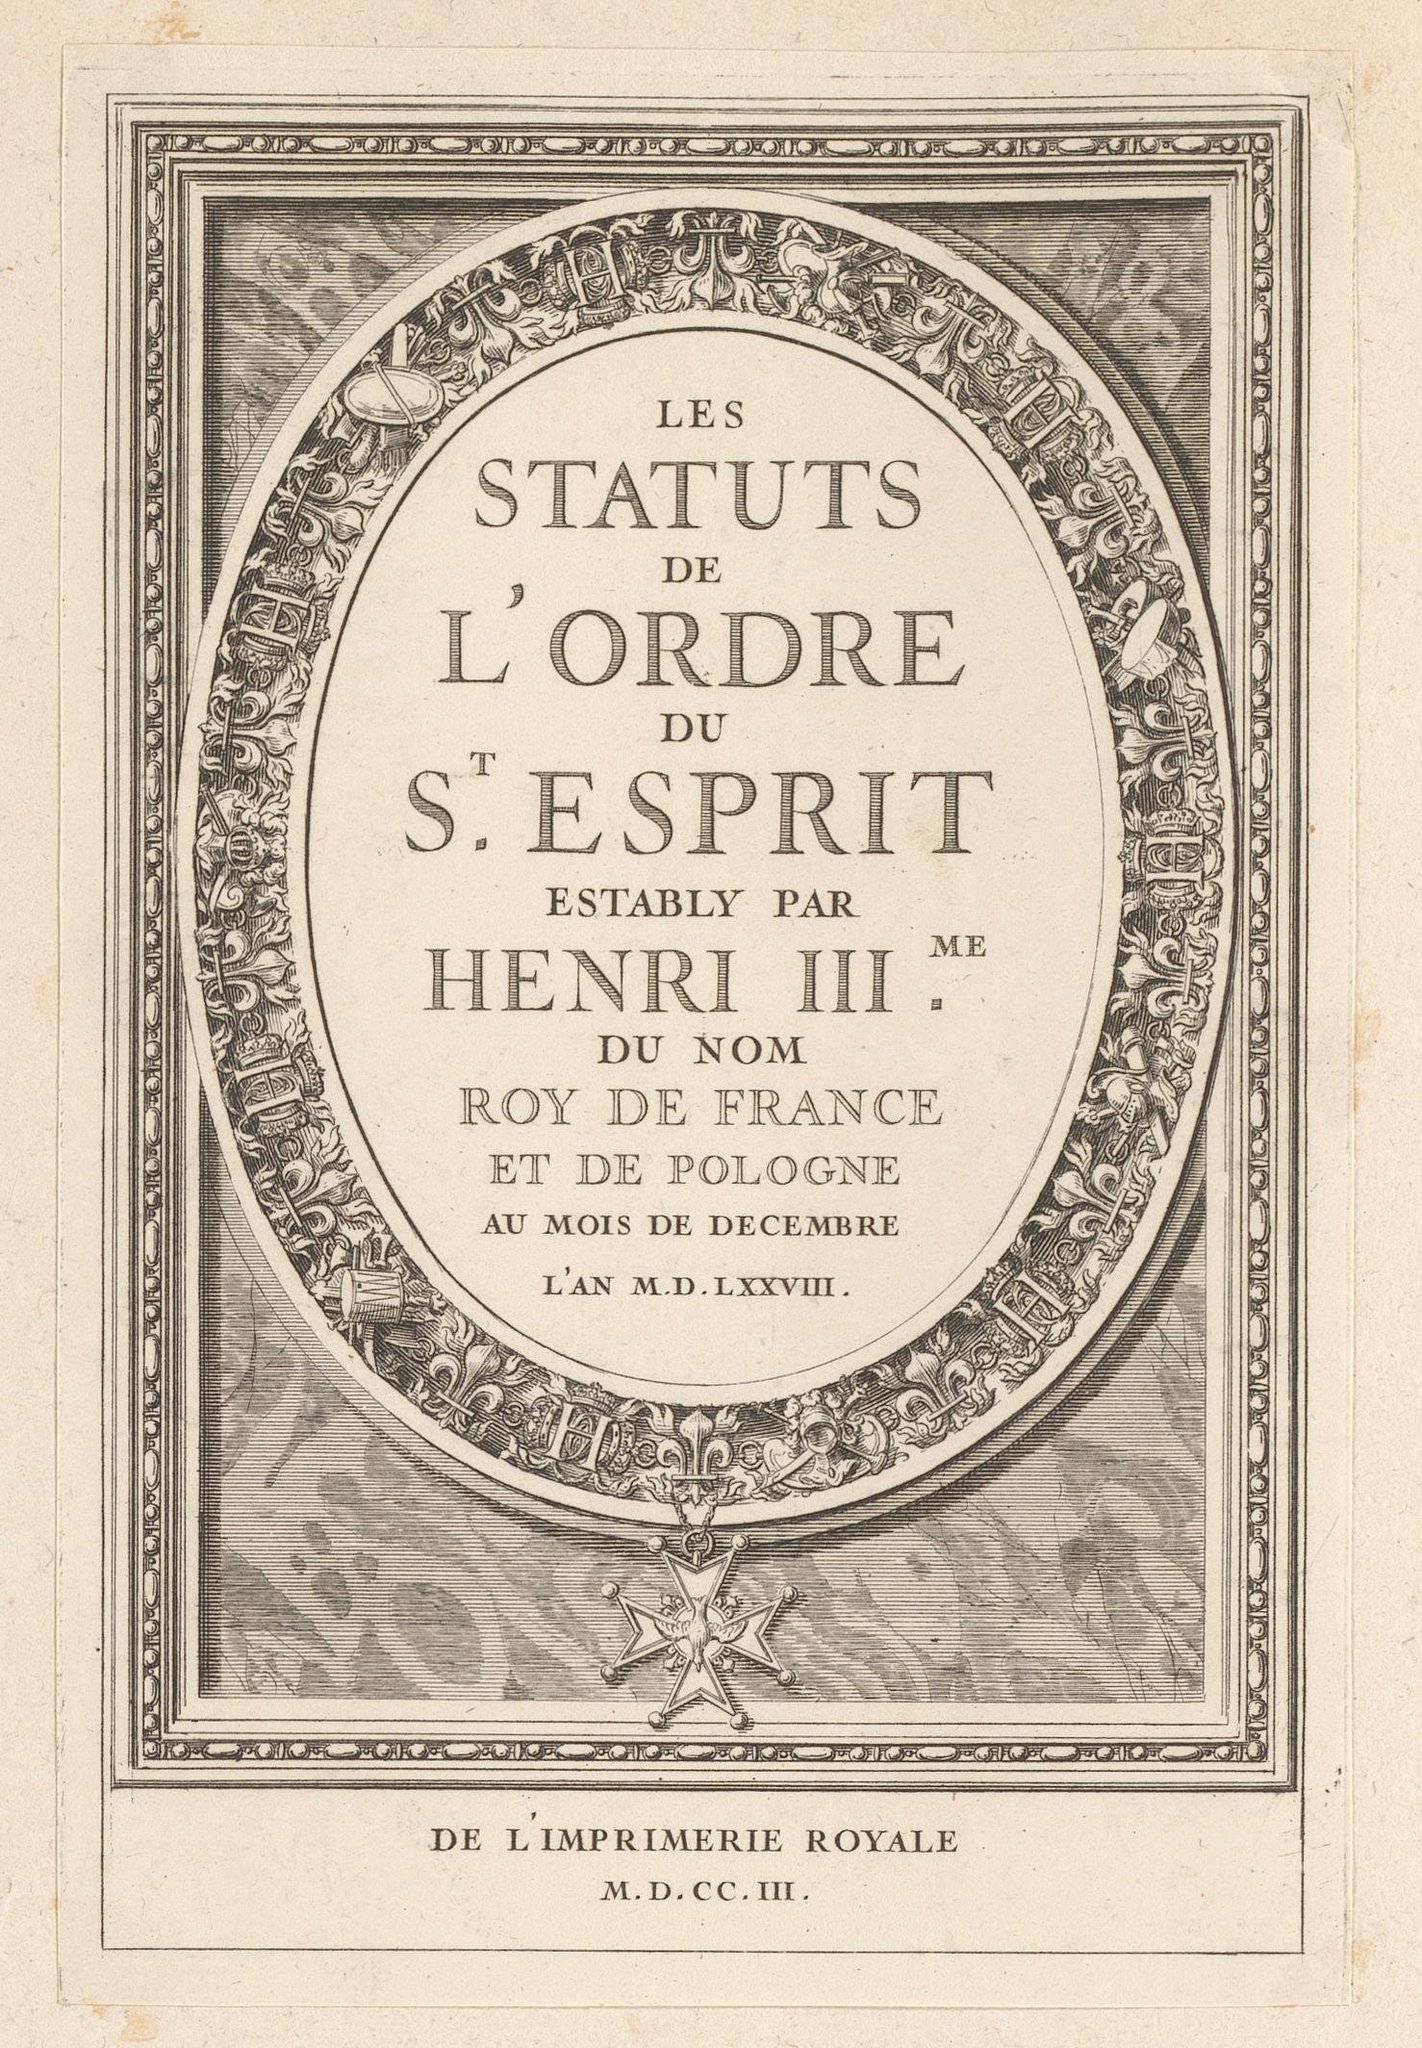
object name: album leaf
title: Titelpagina voor: Les Statuts de l'ordre du Saint-Esprit, 1703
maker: sébastien leclerc (i)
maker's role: print maker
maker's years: 1637-1714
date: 1703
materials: paper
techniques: etching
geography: paris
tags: title-page, knighthood order of the holy spirit - insignia of a knighthood order, e.g.: badge, chain (with name of order)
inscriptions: date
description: Titelpagina voor: Les Statuts de l'ordre du Saint-Esprit. Parijs: Imprimerie Royale, 1703.